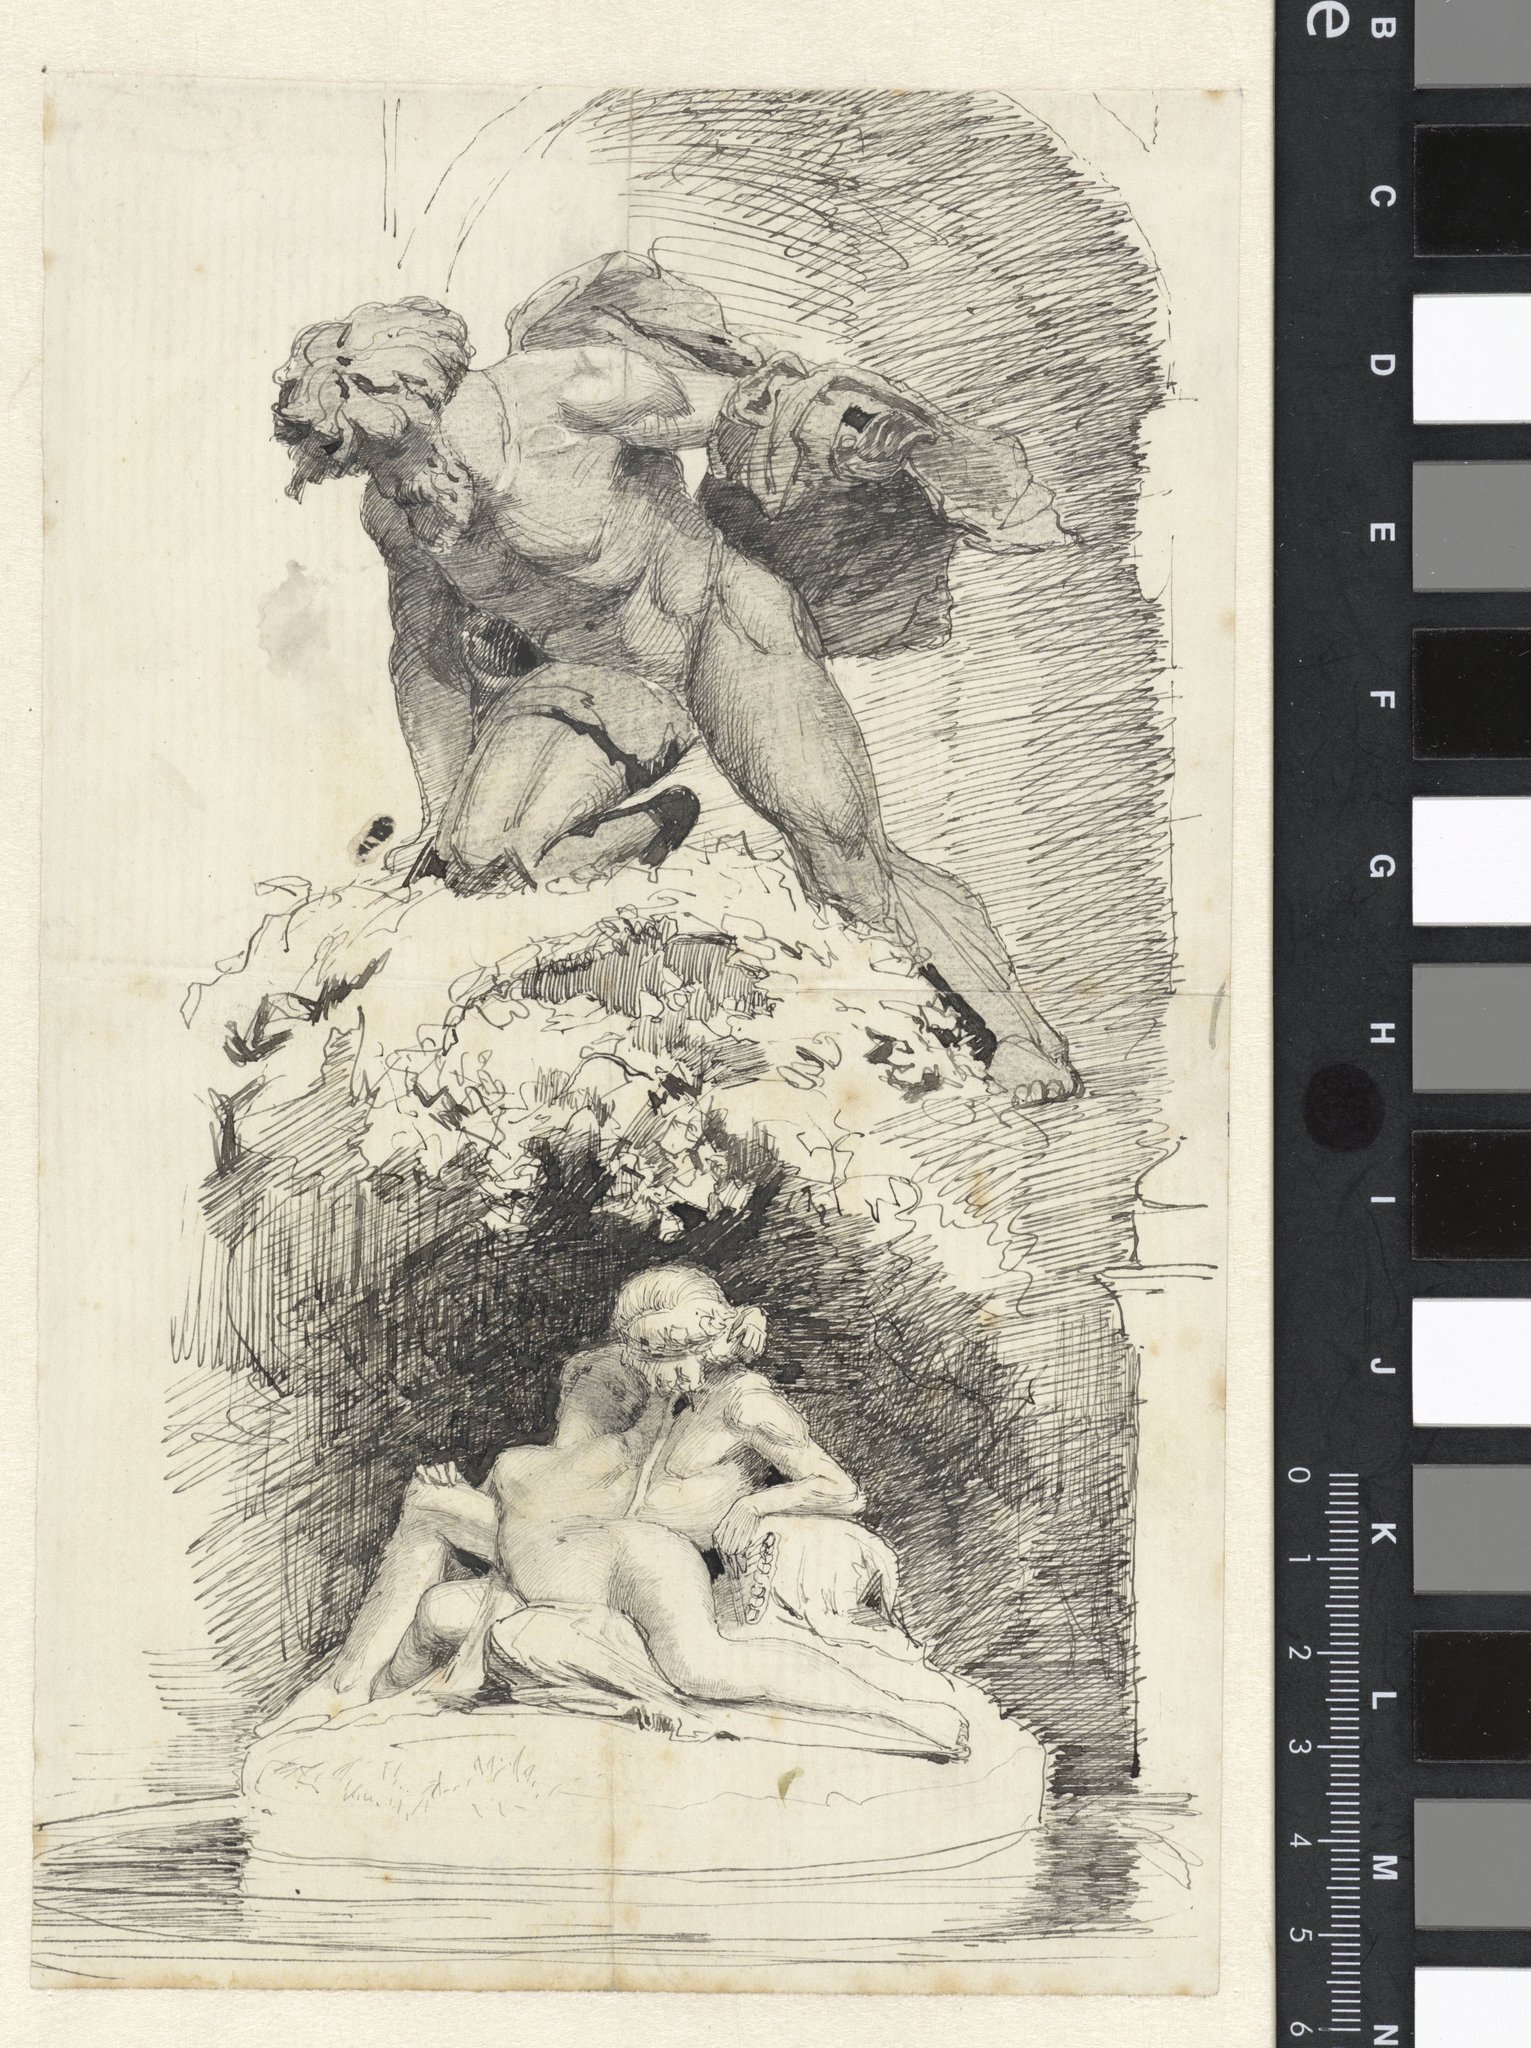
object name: drawing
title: Sculptuur bestaande uit drie figuren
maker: coen metzelaar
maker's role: draughtsman, painter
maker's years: 1845-1881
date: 1855-1881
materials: ink, paper, pencil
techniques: pen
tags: piece of sculpture, reproduction of a piece of sculpture